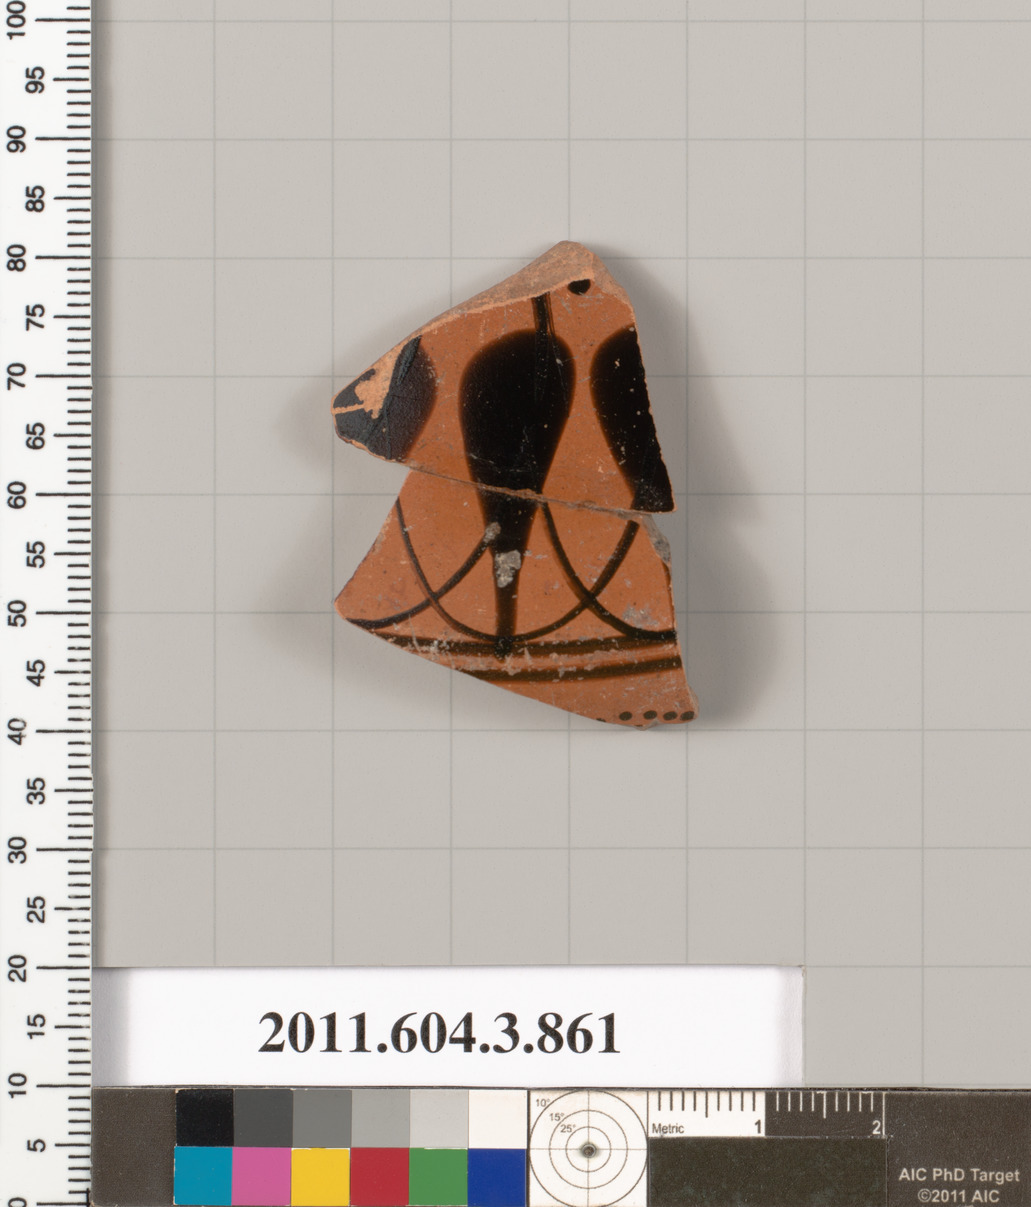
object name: lekythos fragment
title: Terracotta fragment of a lekythos (oil flask)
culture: greek, attic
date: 534-468 BCE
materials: terracotta